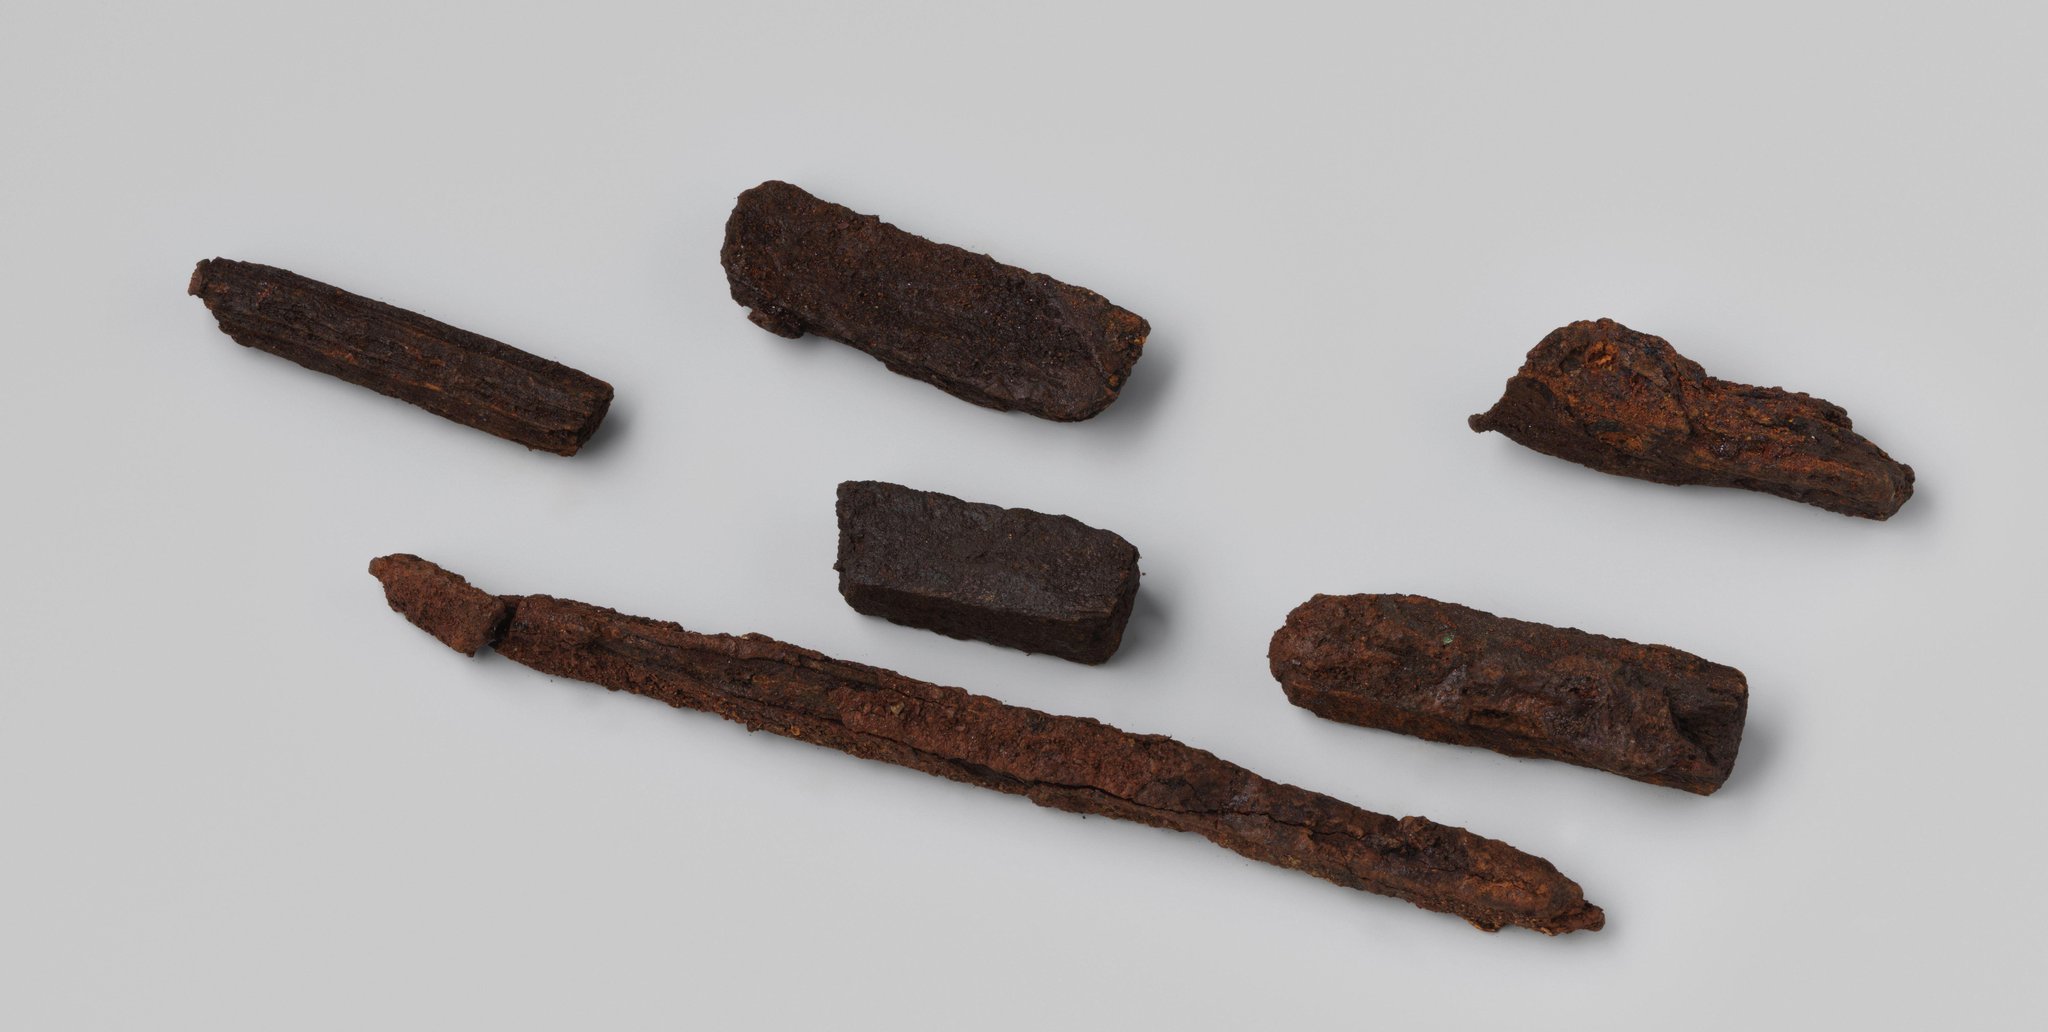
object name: part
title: Fragmenten of onderdelen uit het wrak van de Oost-Indiëvaarder Hollandia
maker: Anonymous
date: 1743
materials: iron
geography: netherlands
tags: verenigde oostindische compagnie, hollandia (schip), annet